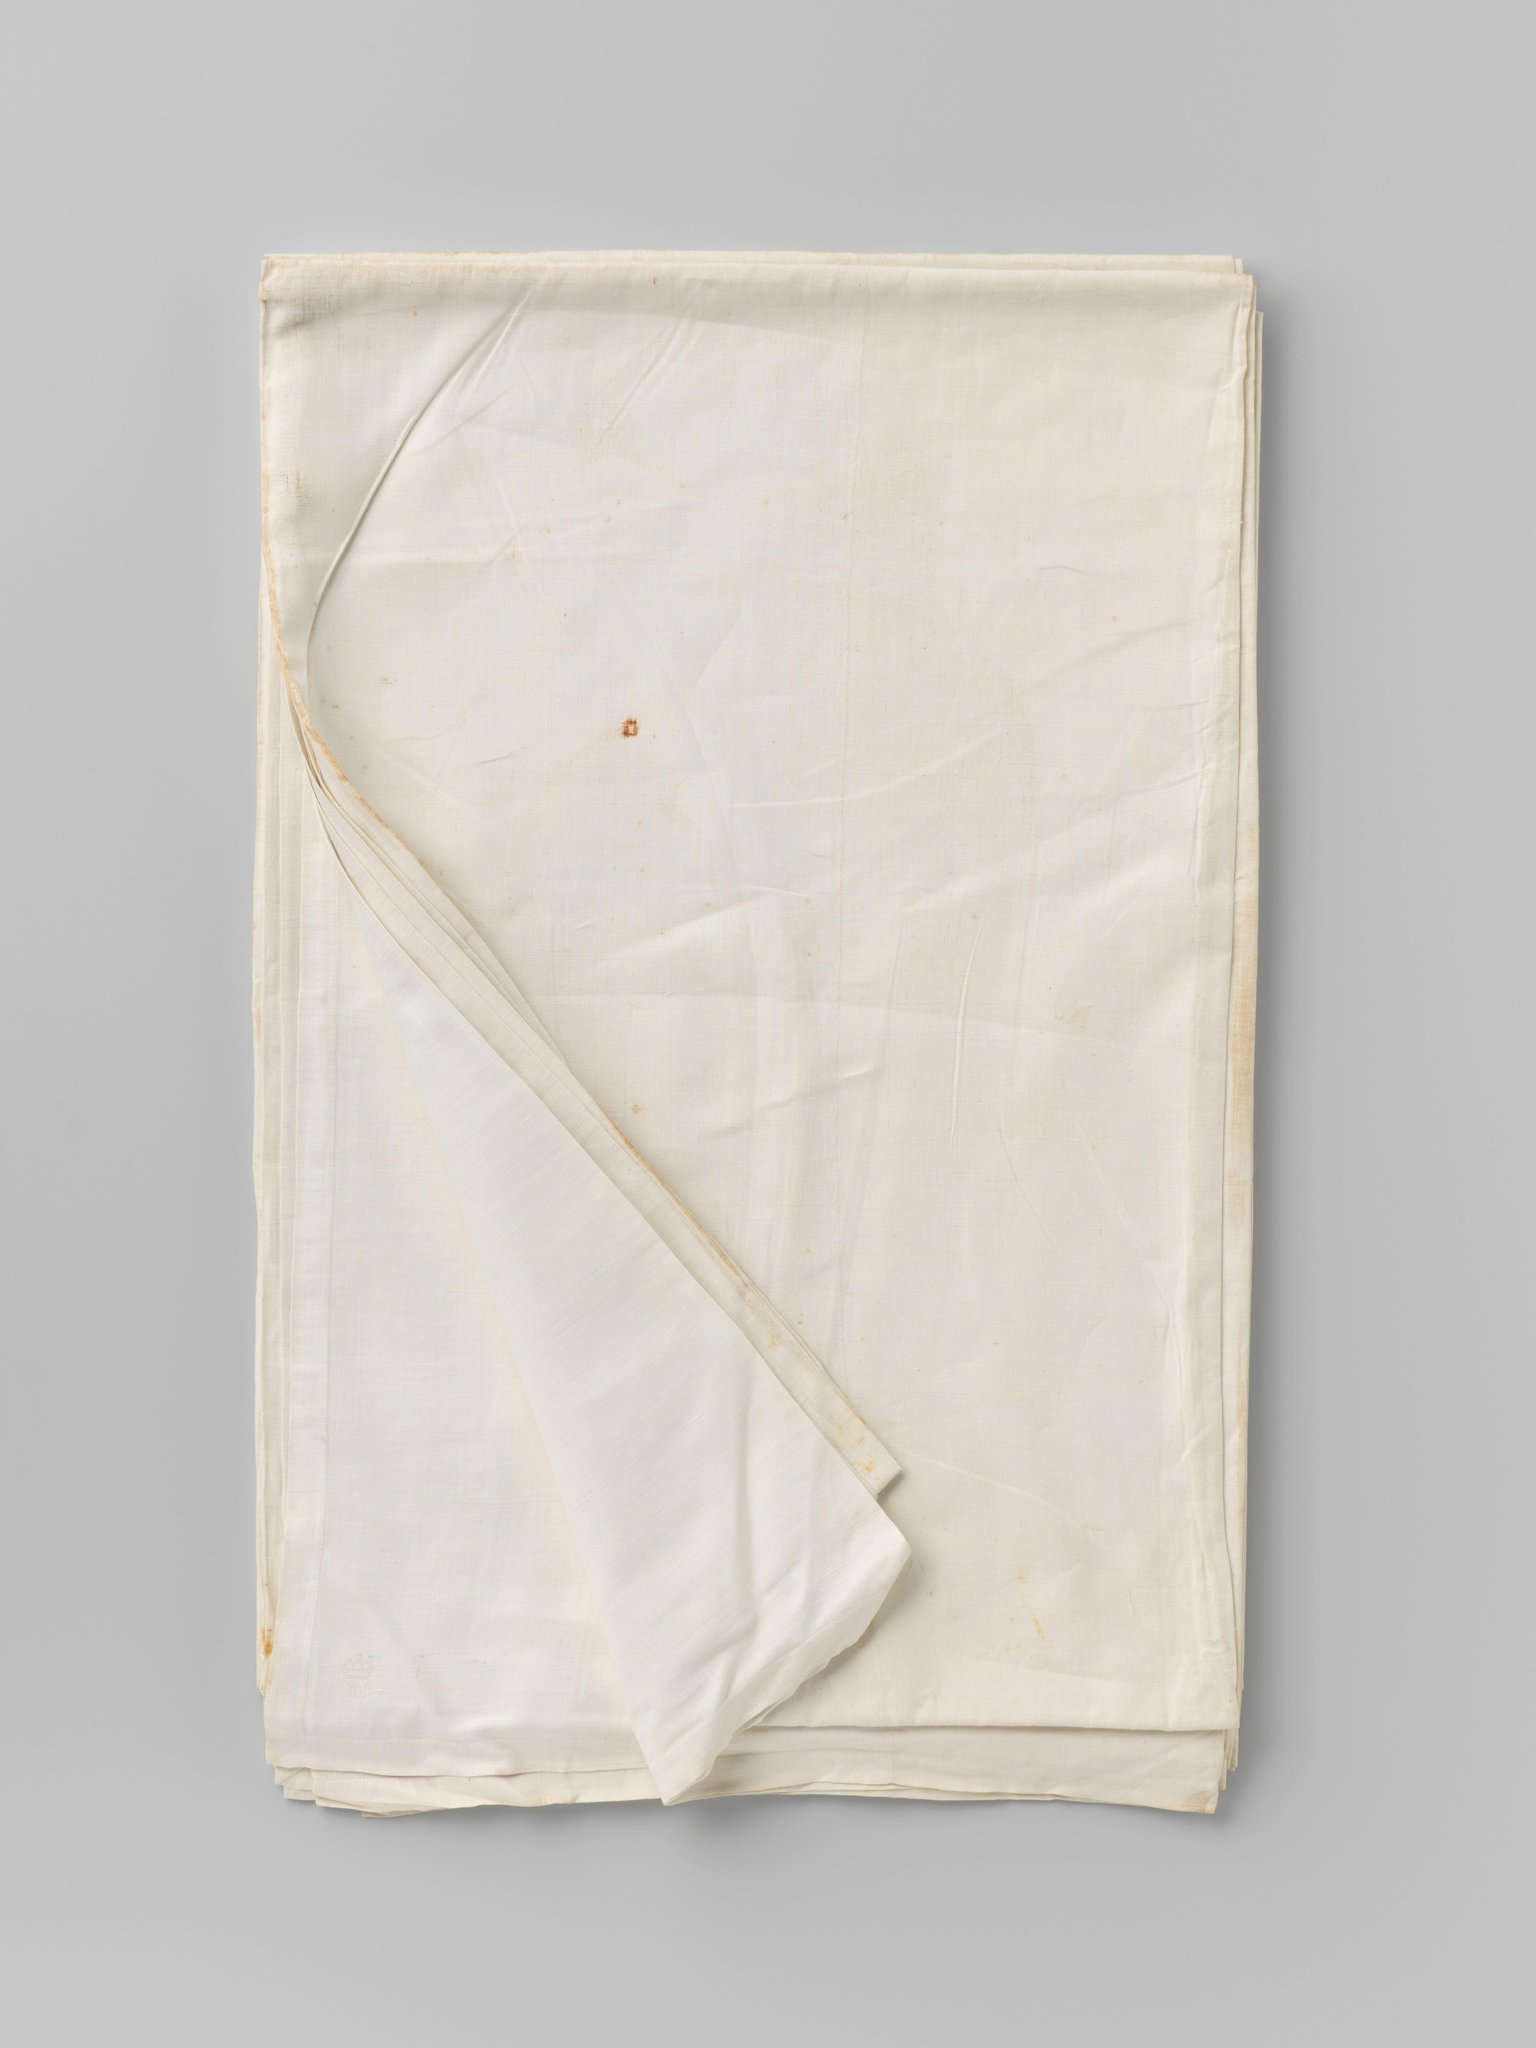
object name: beddenlaken, laken object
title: Laken. Merk: kroon WG en jaartal 1737 en HW21.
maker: Anonymous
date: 1737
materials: linen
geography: northern netherlands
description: Laken van wit linnen, merk kroon WG en jaartal 1737 en HW2 1